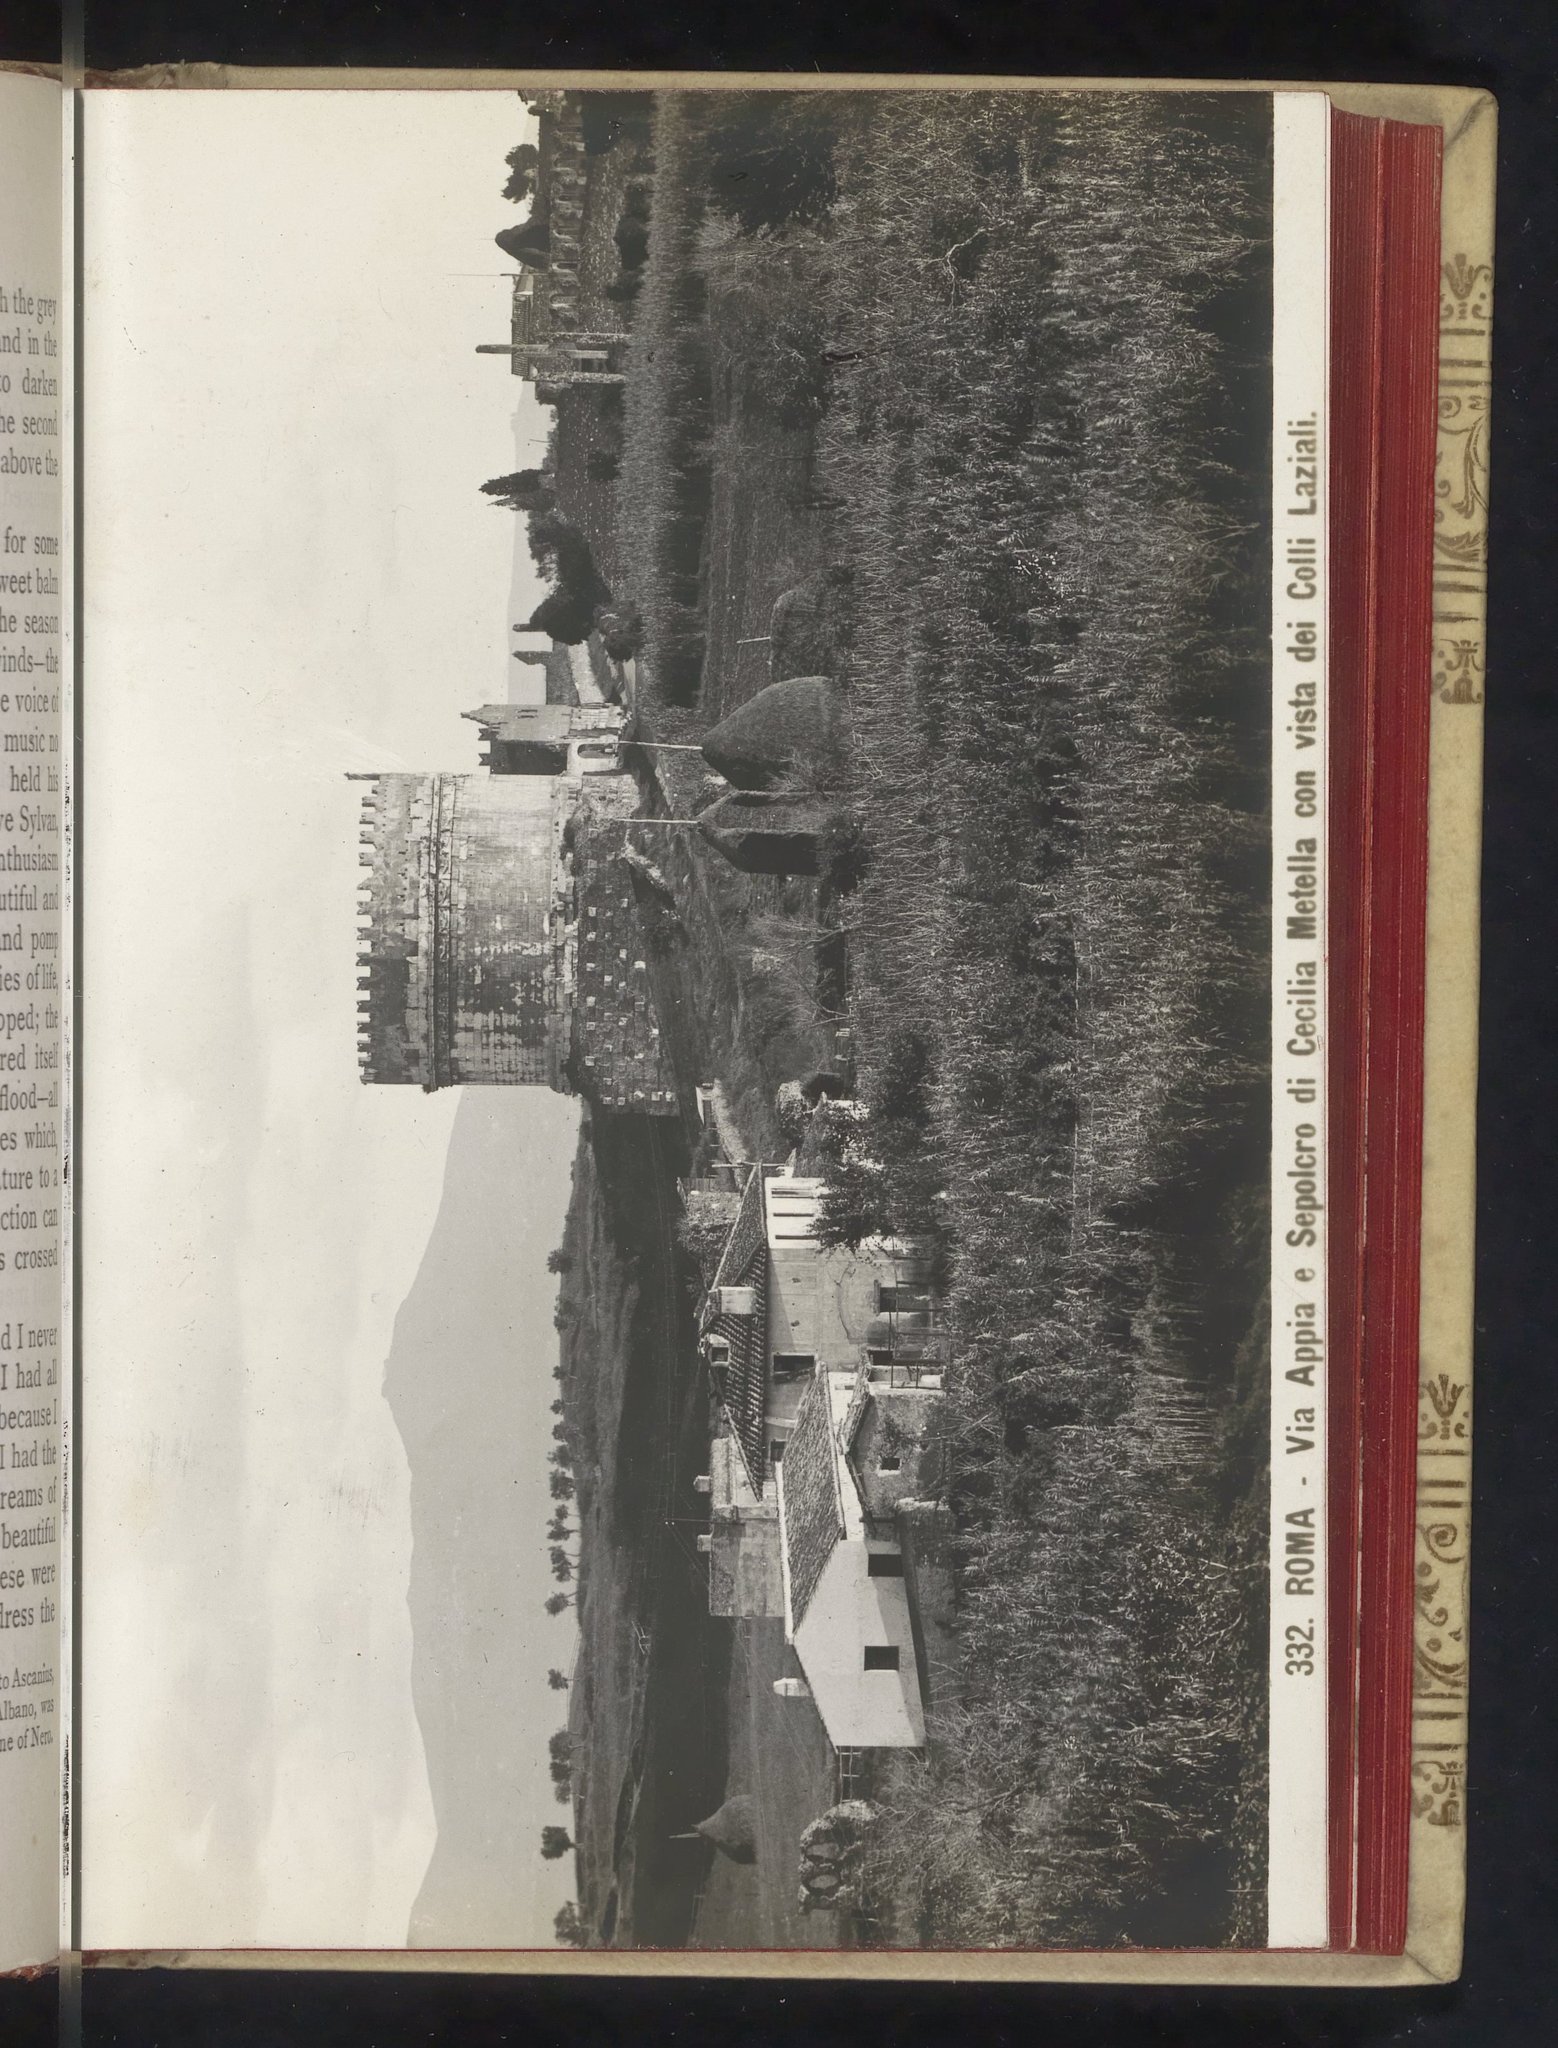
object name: page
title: Roma - Via Appia e Sepolcro di Cecilia Metella con vista dei Colli Laziali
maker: Anonymous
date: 1895-1915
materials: photographic support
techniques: gelatin silver print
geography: lazio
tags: mausoleum, façade (of house or building)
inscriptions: number: ‘332.’